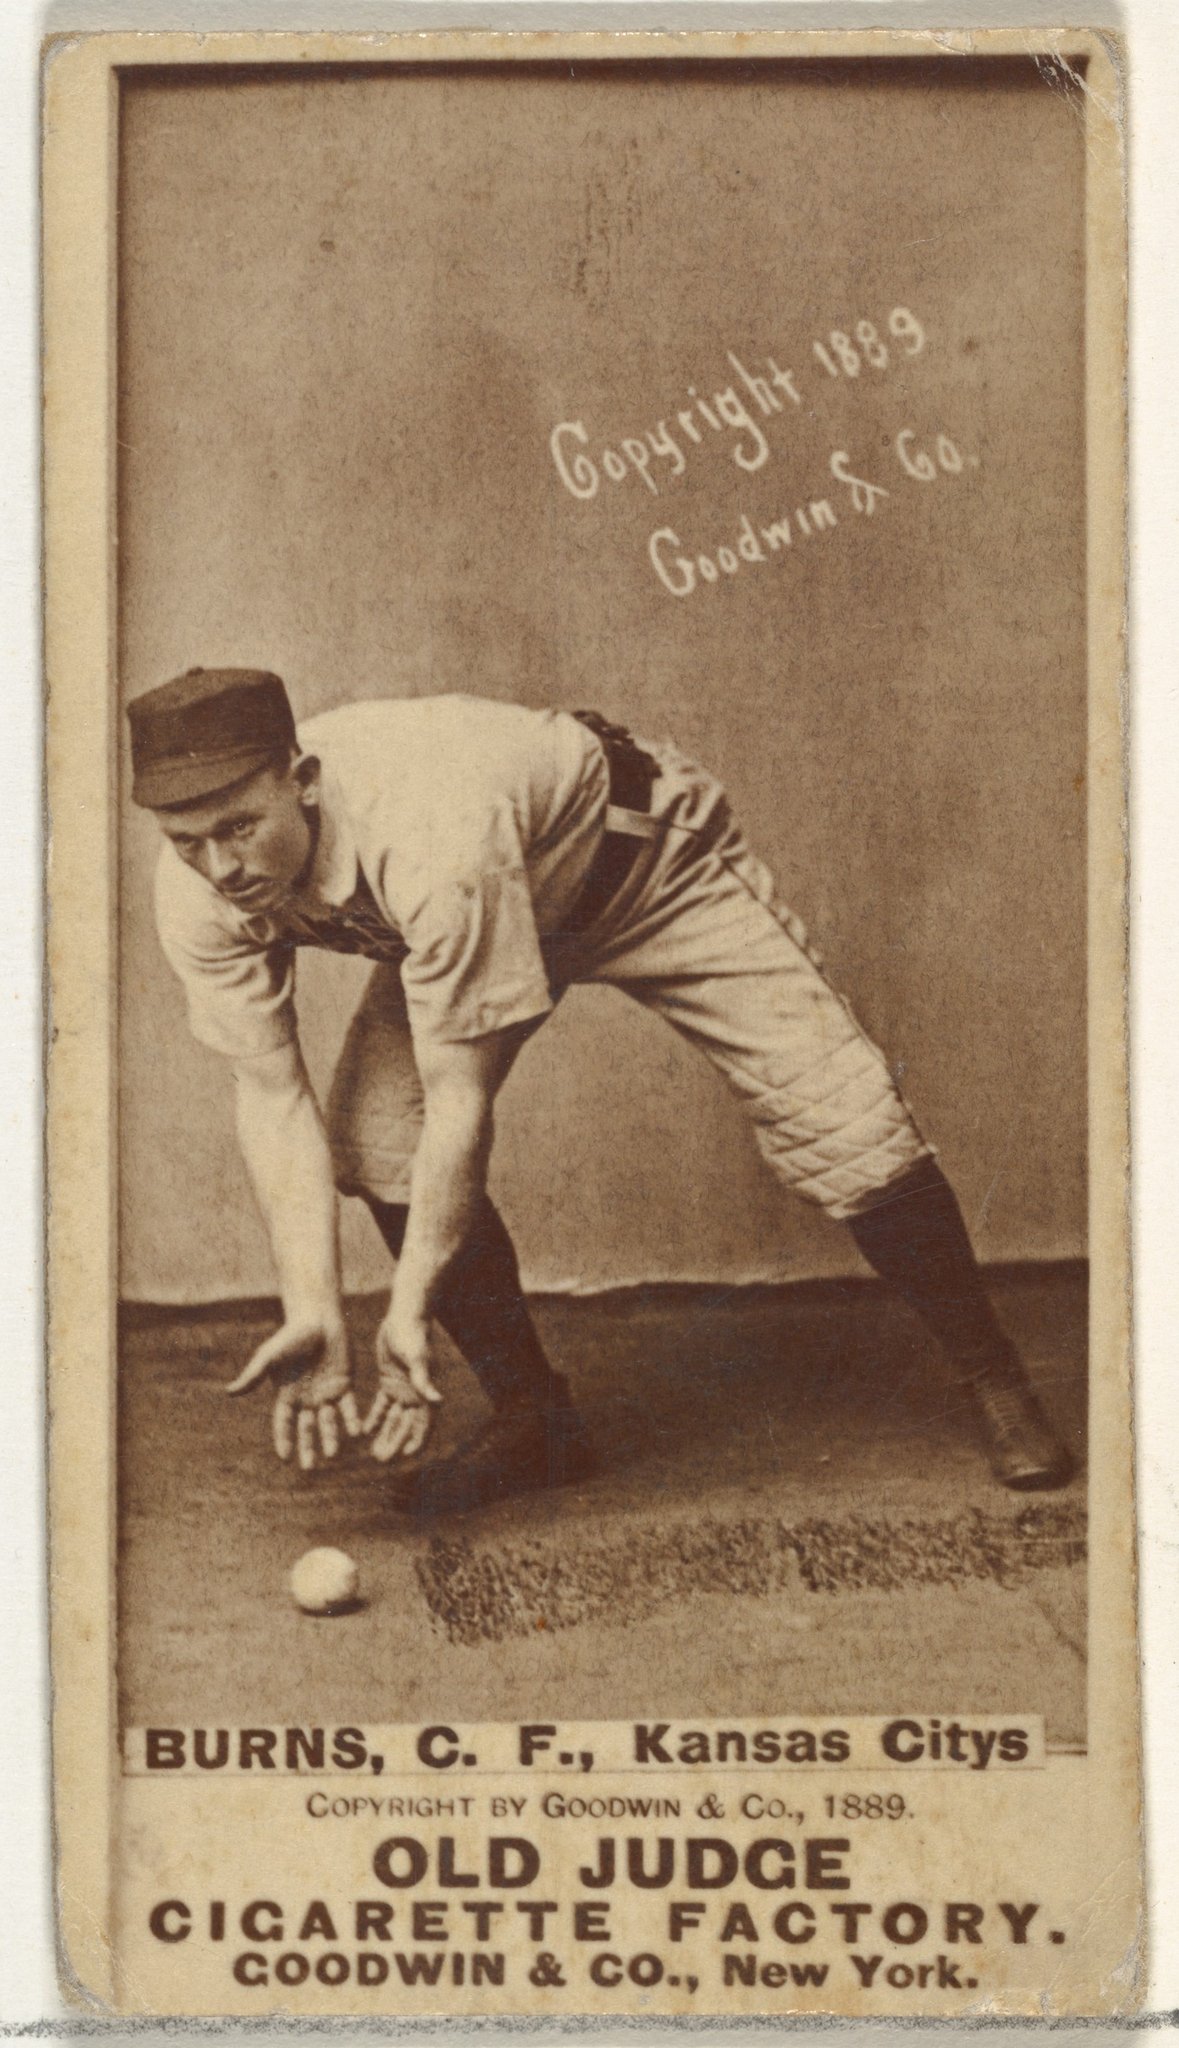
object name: baseball card, photograph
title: James M. "Jim" Burns, Center Field, Kansas City Cowboys, from the Old Judge series (N172) for Old Judge Cigarettes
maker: goodwin & company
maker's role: publisher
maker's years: 1850-1950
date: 1889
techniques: albumen silver print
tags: men,portraits,baseball,athletes